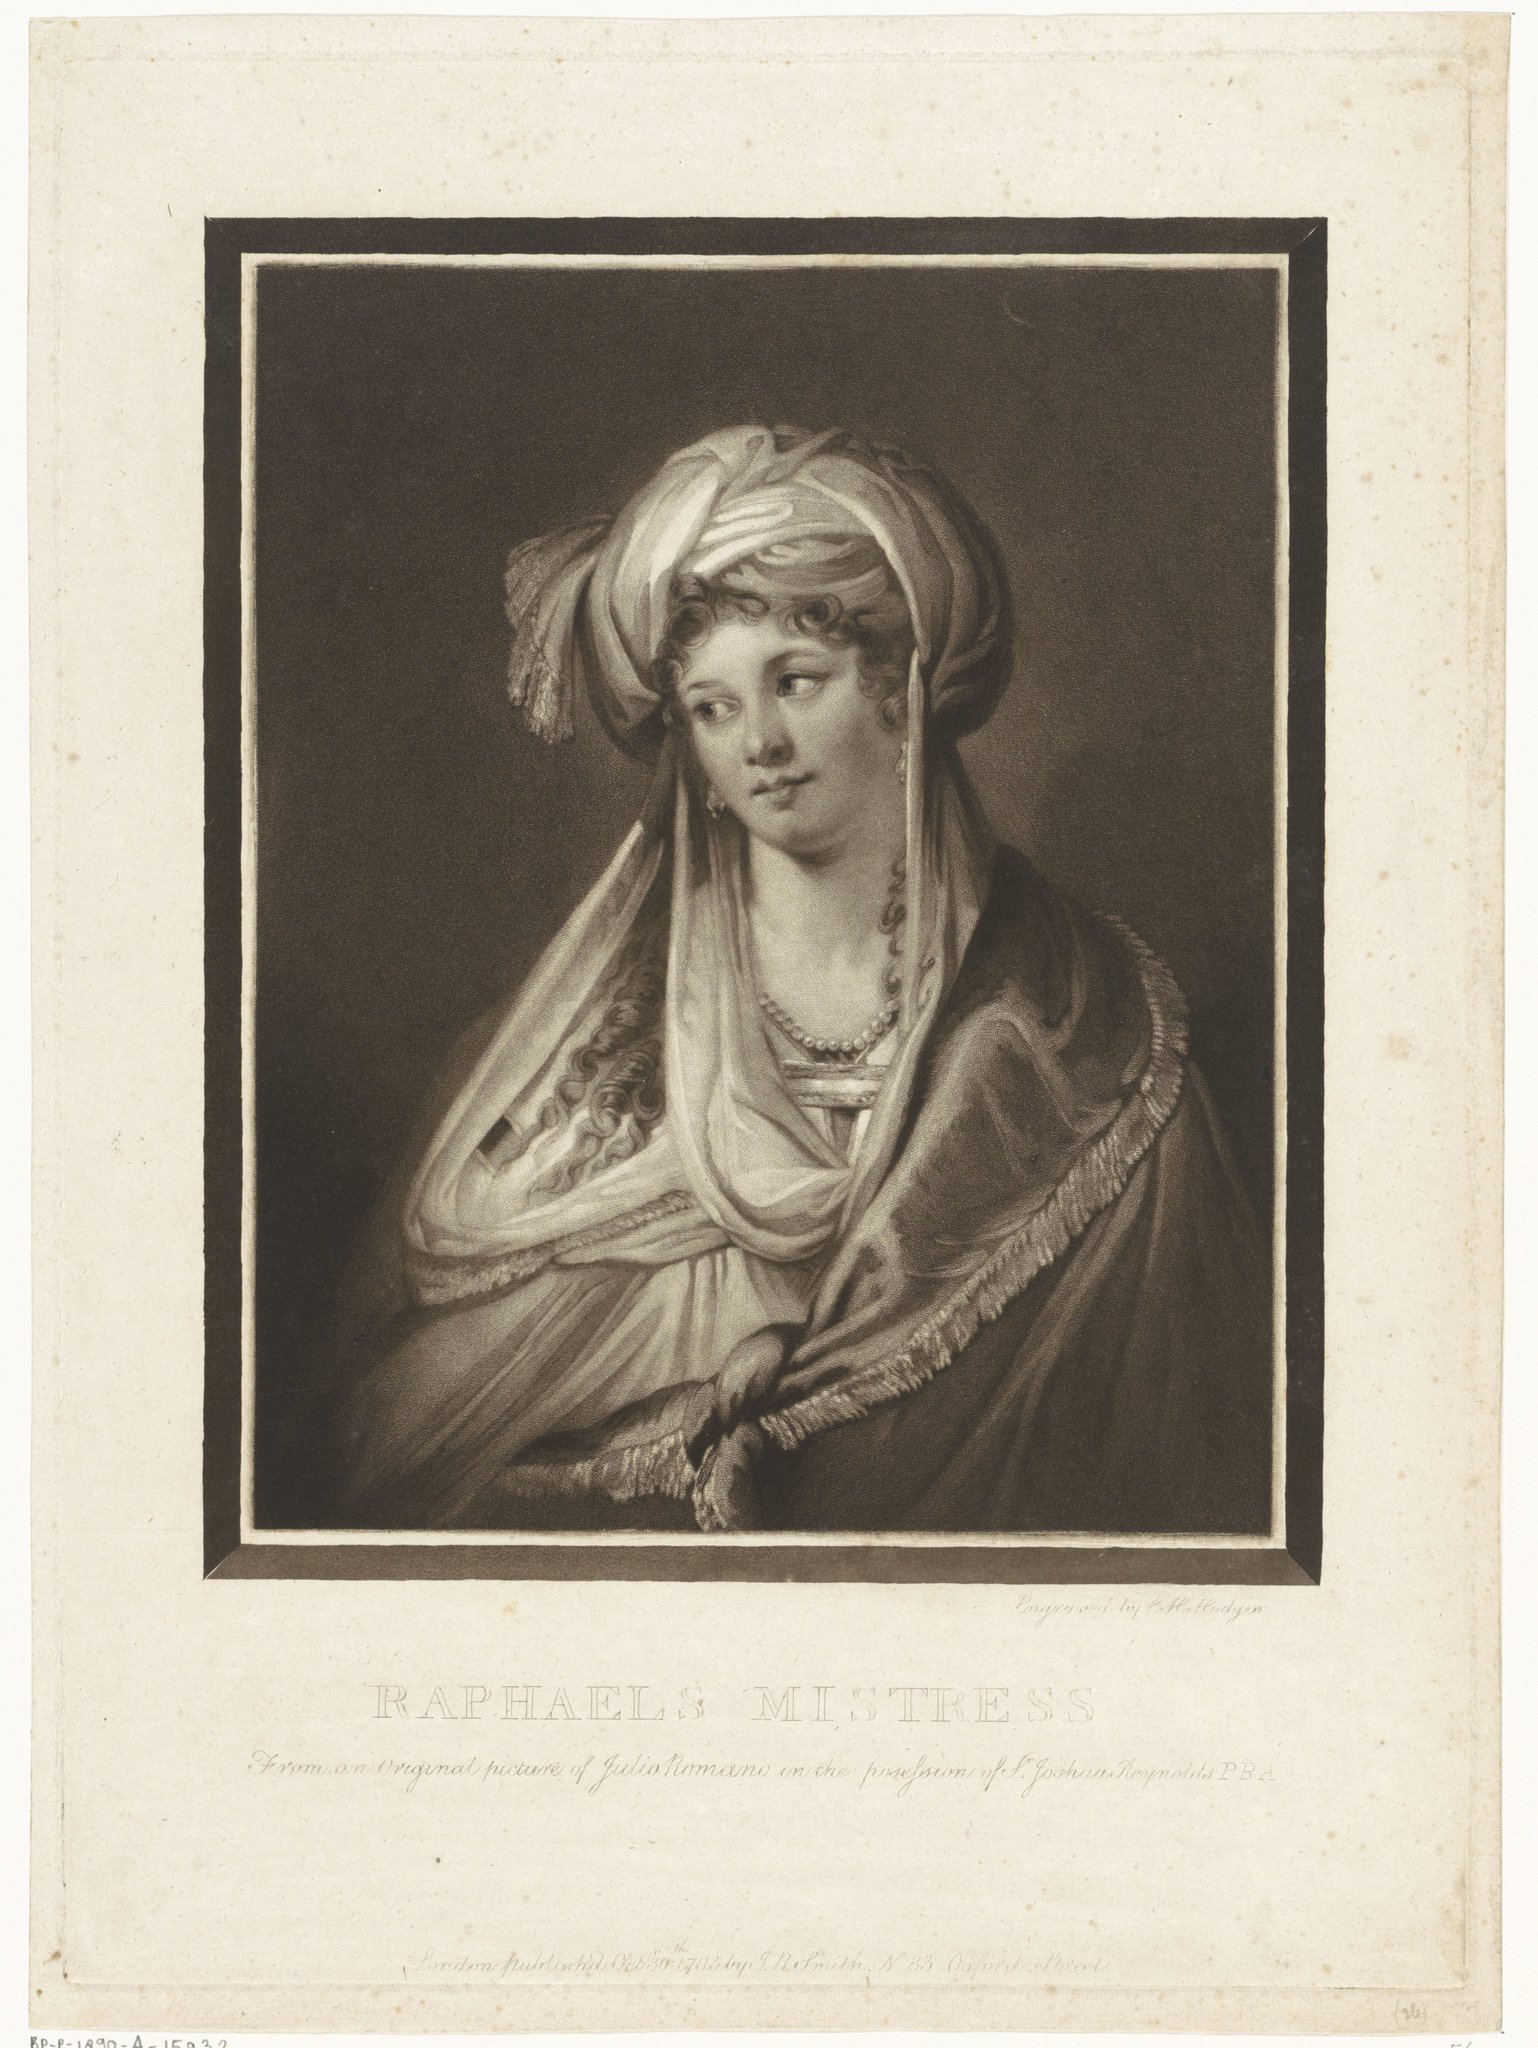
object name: print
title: De maitresse van Raphael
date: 1785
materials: paper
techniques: engraving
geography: london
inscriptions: collector's mark: Lugt 2228